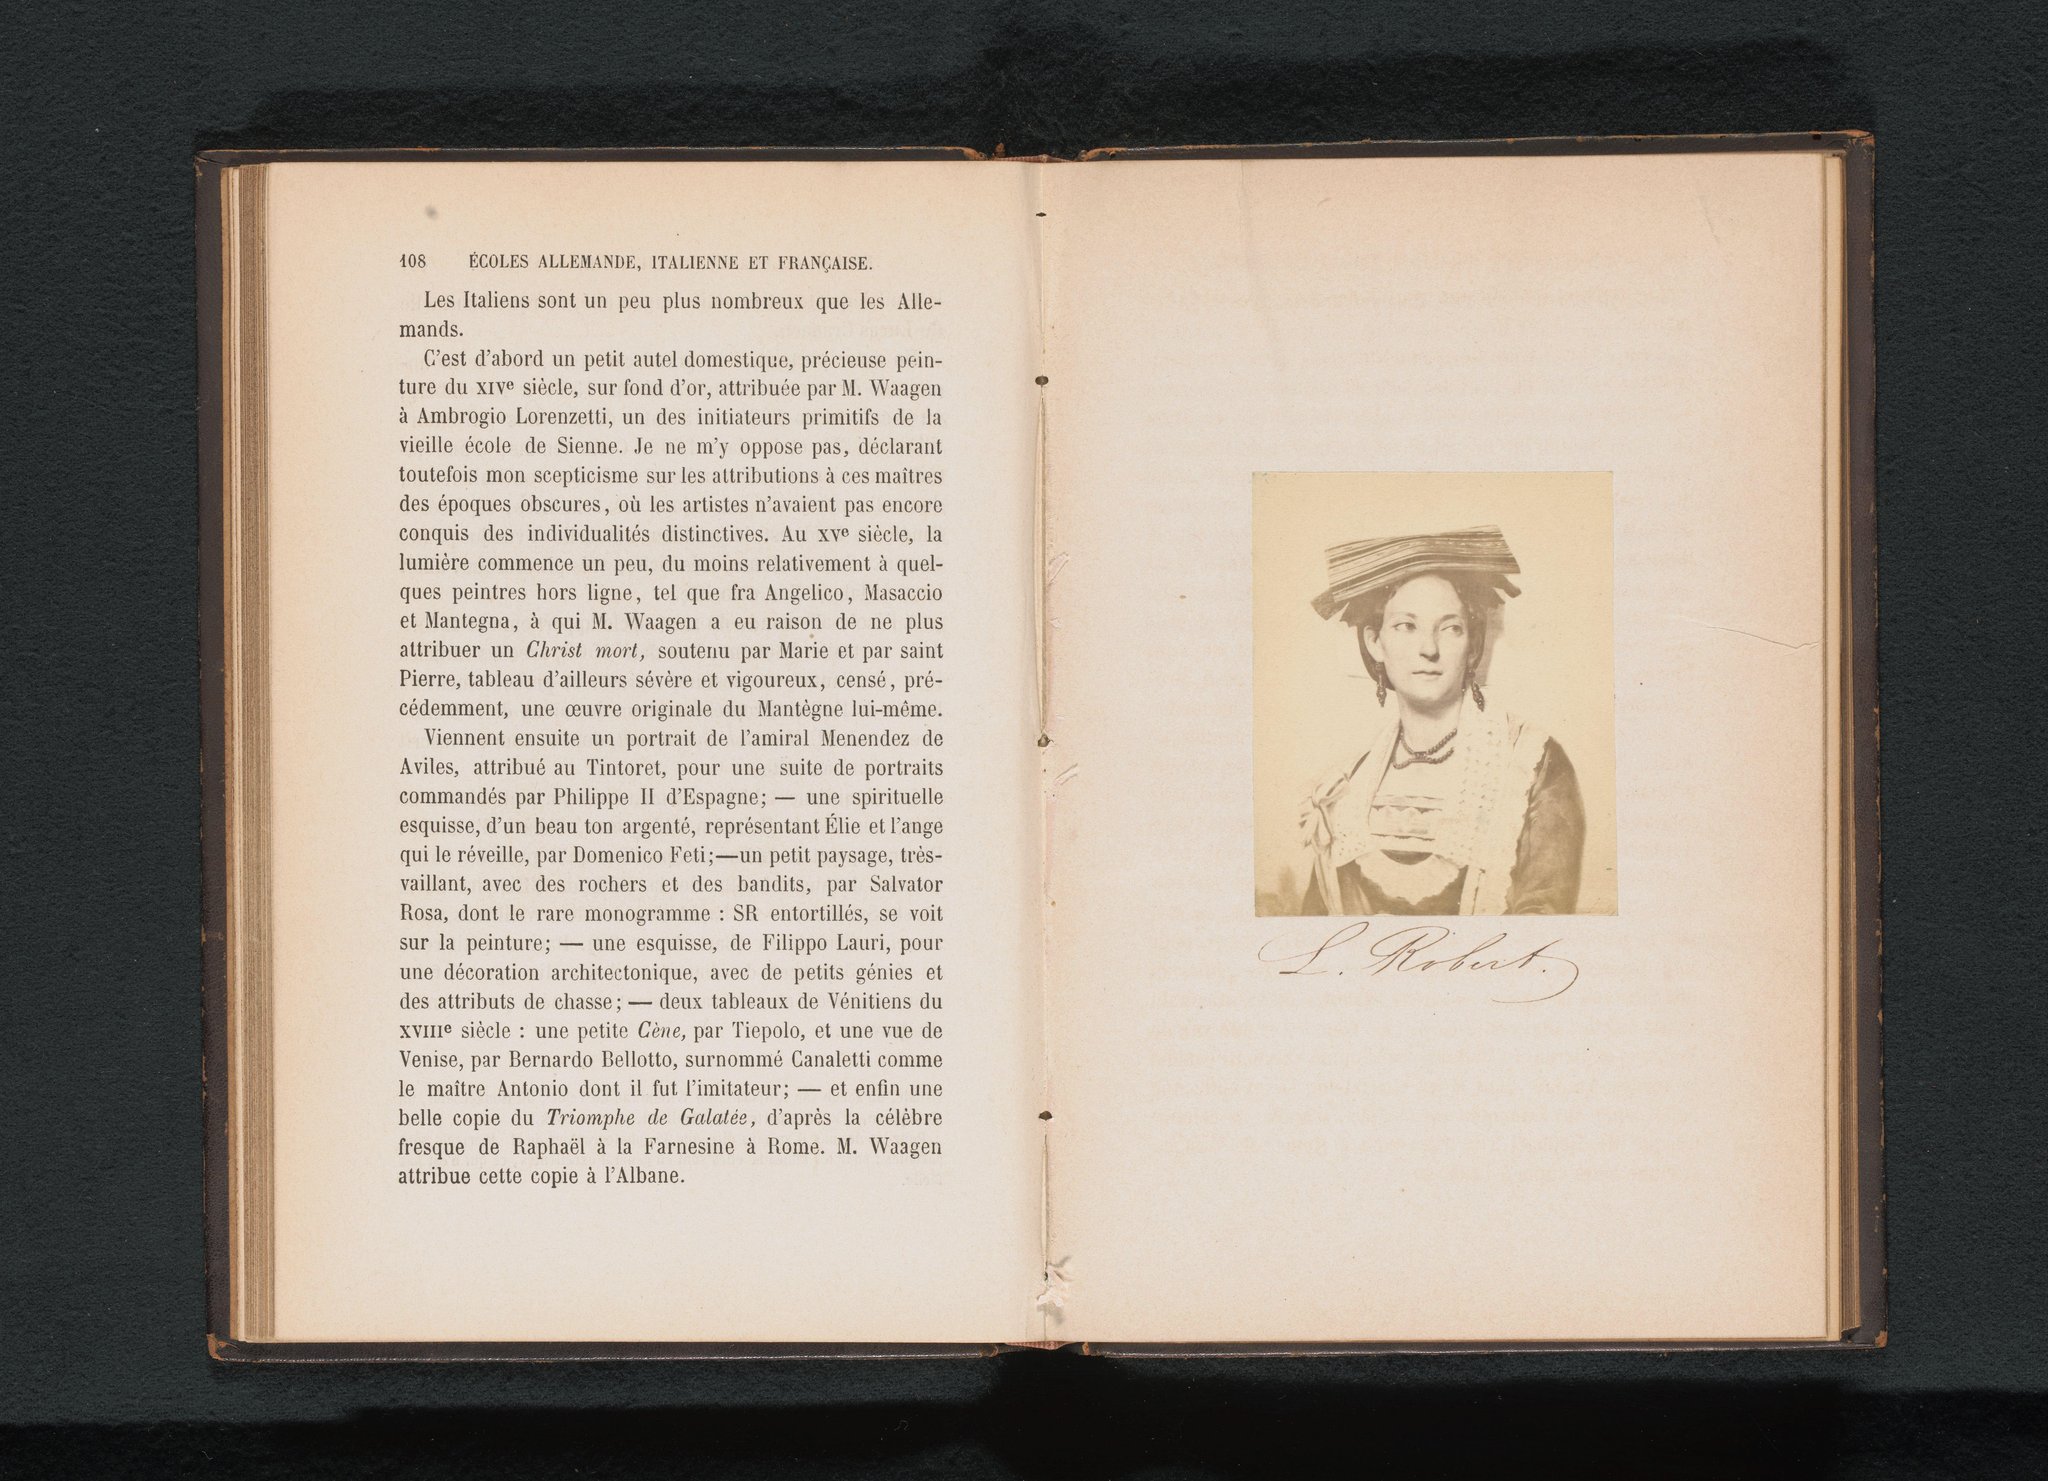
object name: page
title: Portret van een onbekende vrouw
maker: edmond fierlants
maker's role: fotograaf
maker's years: 1819-1869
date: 1855-1860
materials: photographic support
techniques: albumen print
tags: historical persons - bb - woman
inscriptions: name: ‘L. Robert.’